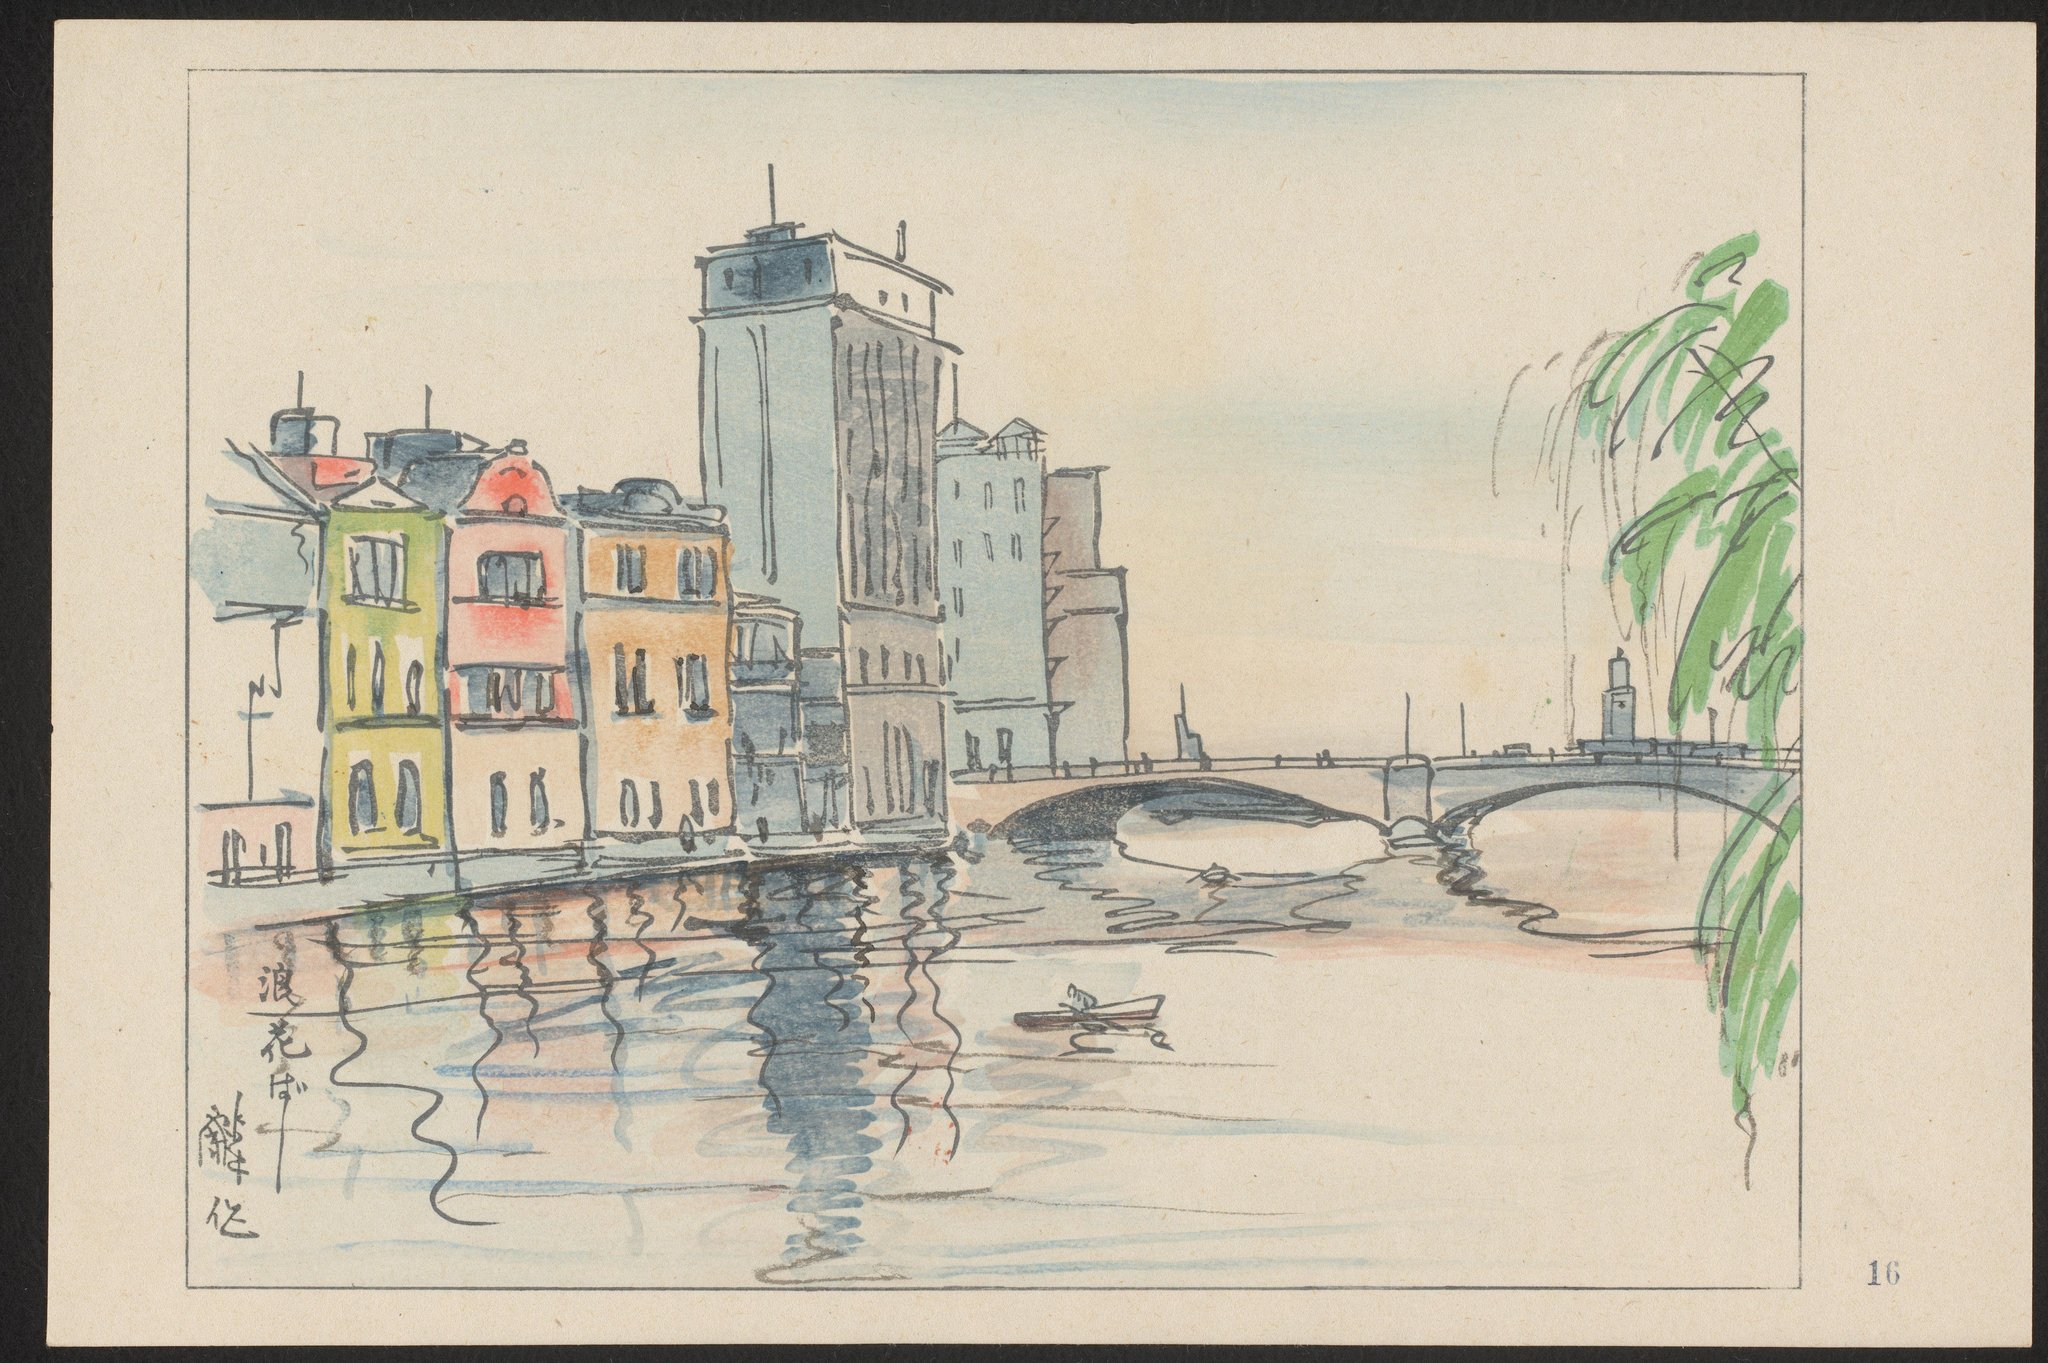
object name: print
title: Naniwabashi bridge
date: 1947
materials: paper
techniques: woodcut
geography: japan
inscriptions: date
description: De Naniwabashi brug over de oude Yodo rivier, met pakhuizen langs de oever.